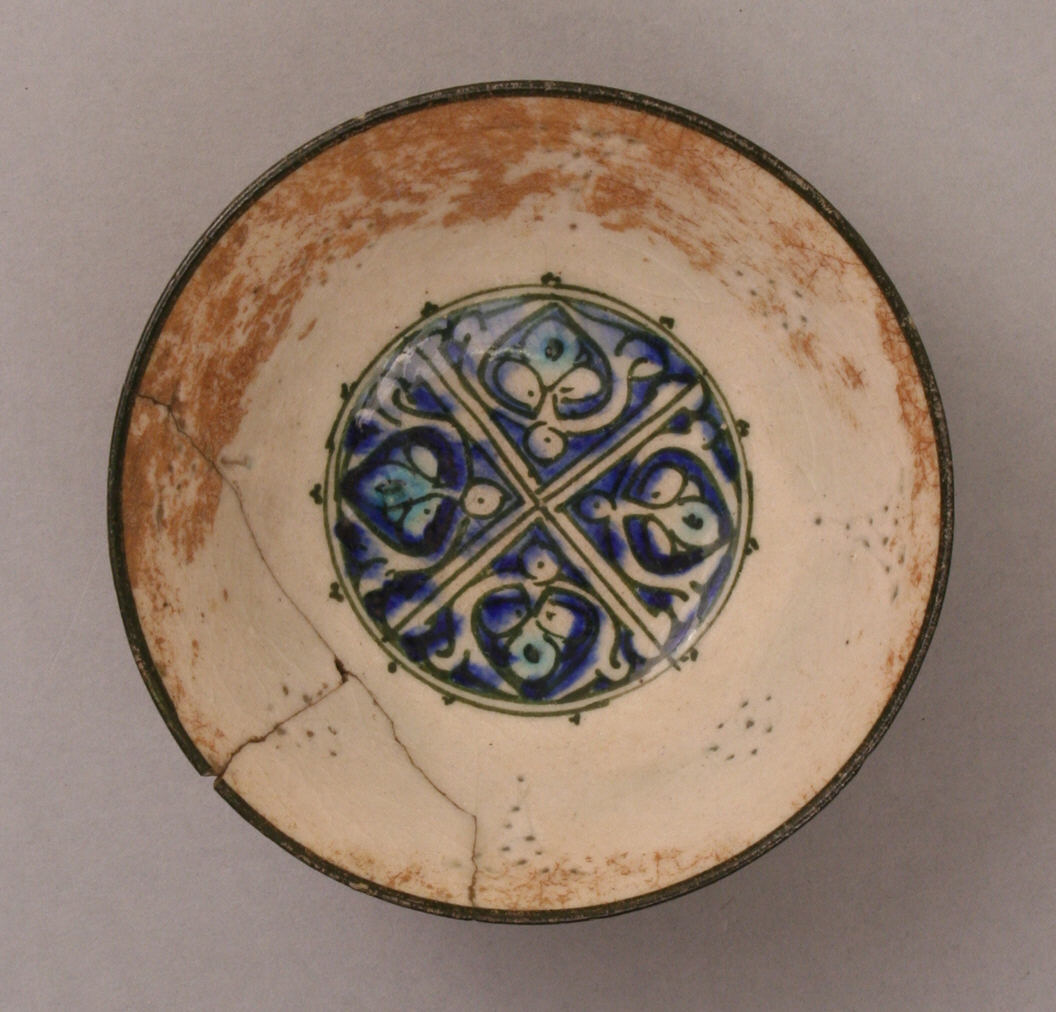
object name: bowl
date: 1201-1400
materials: stonepaste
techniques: glazing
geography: iran